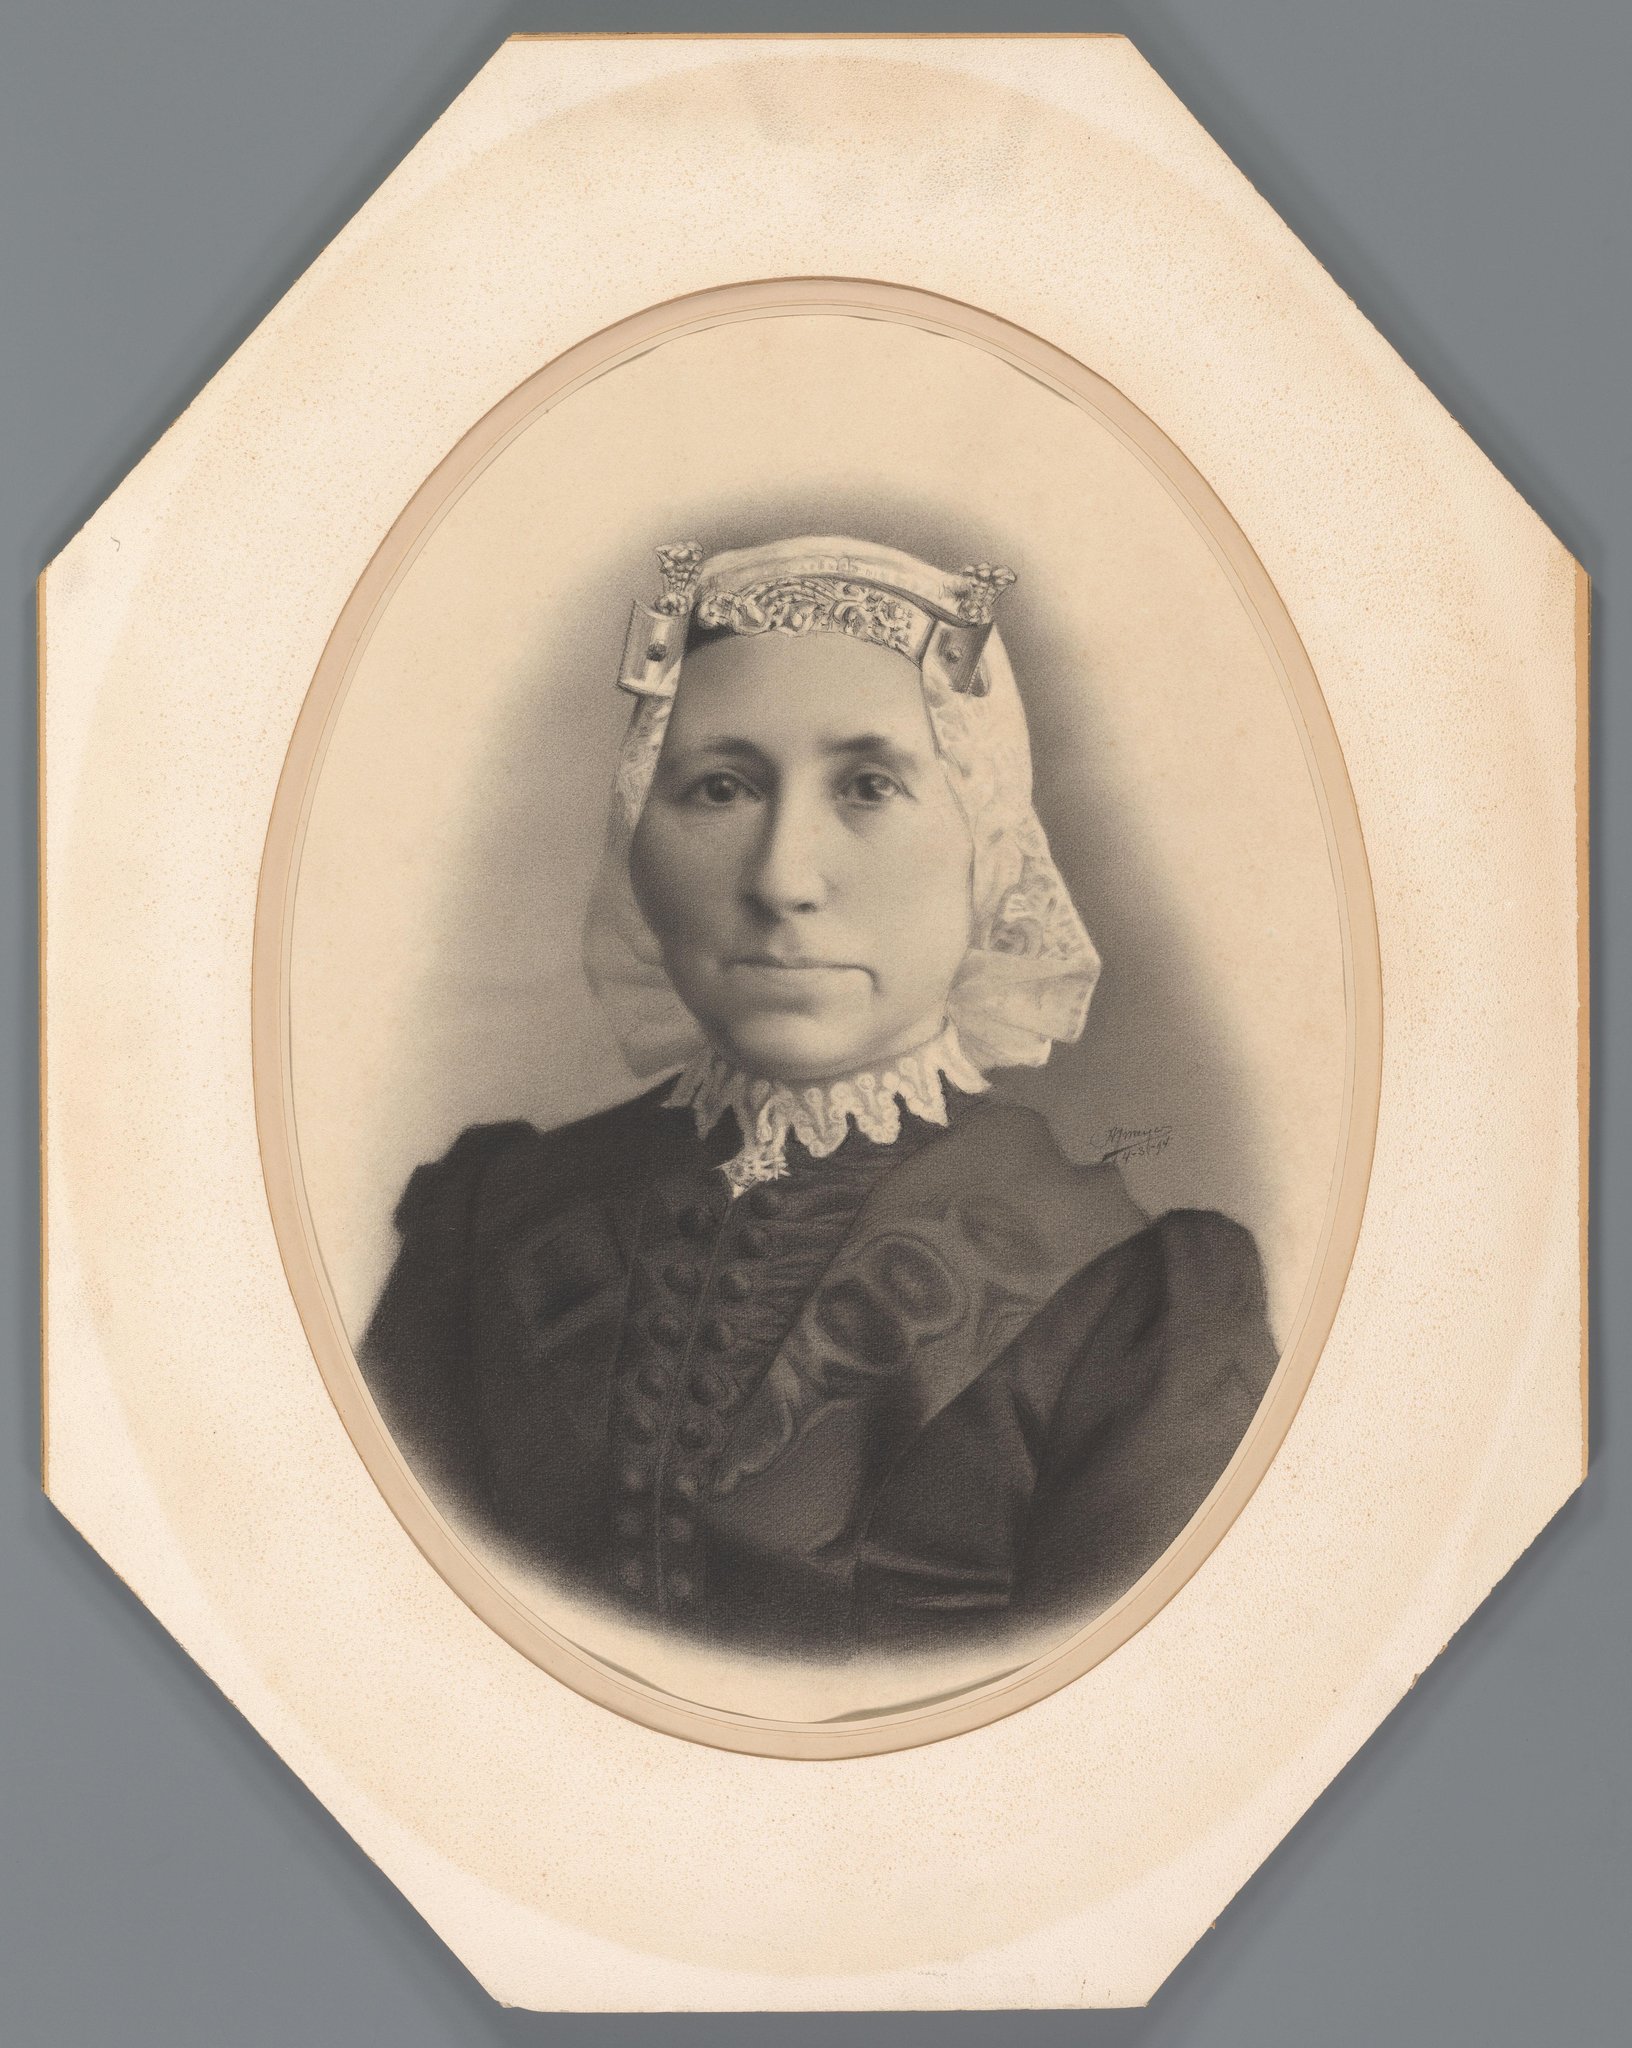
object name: crayon enlargement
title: Portret van een onbekende Zeeuwse vrouw in klederdracht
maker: a.j. meijer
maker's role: fotograaf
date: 1894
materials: paper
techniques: gelatin silver print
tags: folk costume, regional costume, anonymous historical person portrayed - bb - woman